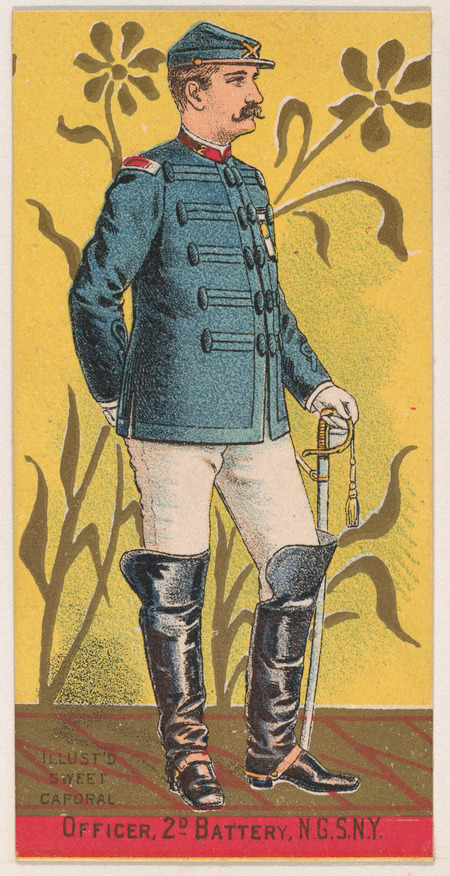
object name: print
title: Officer, 2nd Battery, National Guard of the State of New York, from the Military Series (N224) issued by Kinney Tobacco Company to promote Sweet Caporal Cigarettes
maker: kinney brothers tobacco company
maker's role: publisher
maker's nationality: american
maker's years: 1869-2011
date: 1888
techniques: color lithograph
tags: military,swords,men,profiles